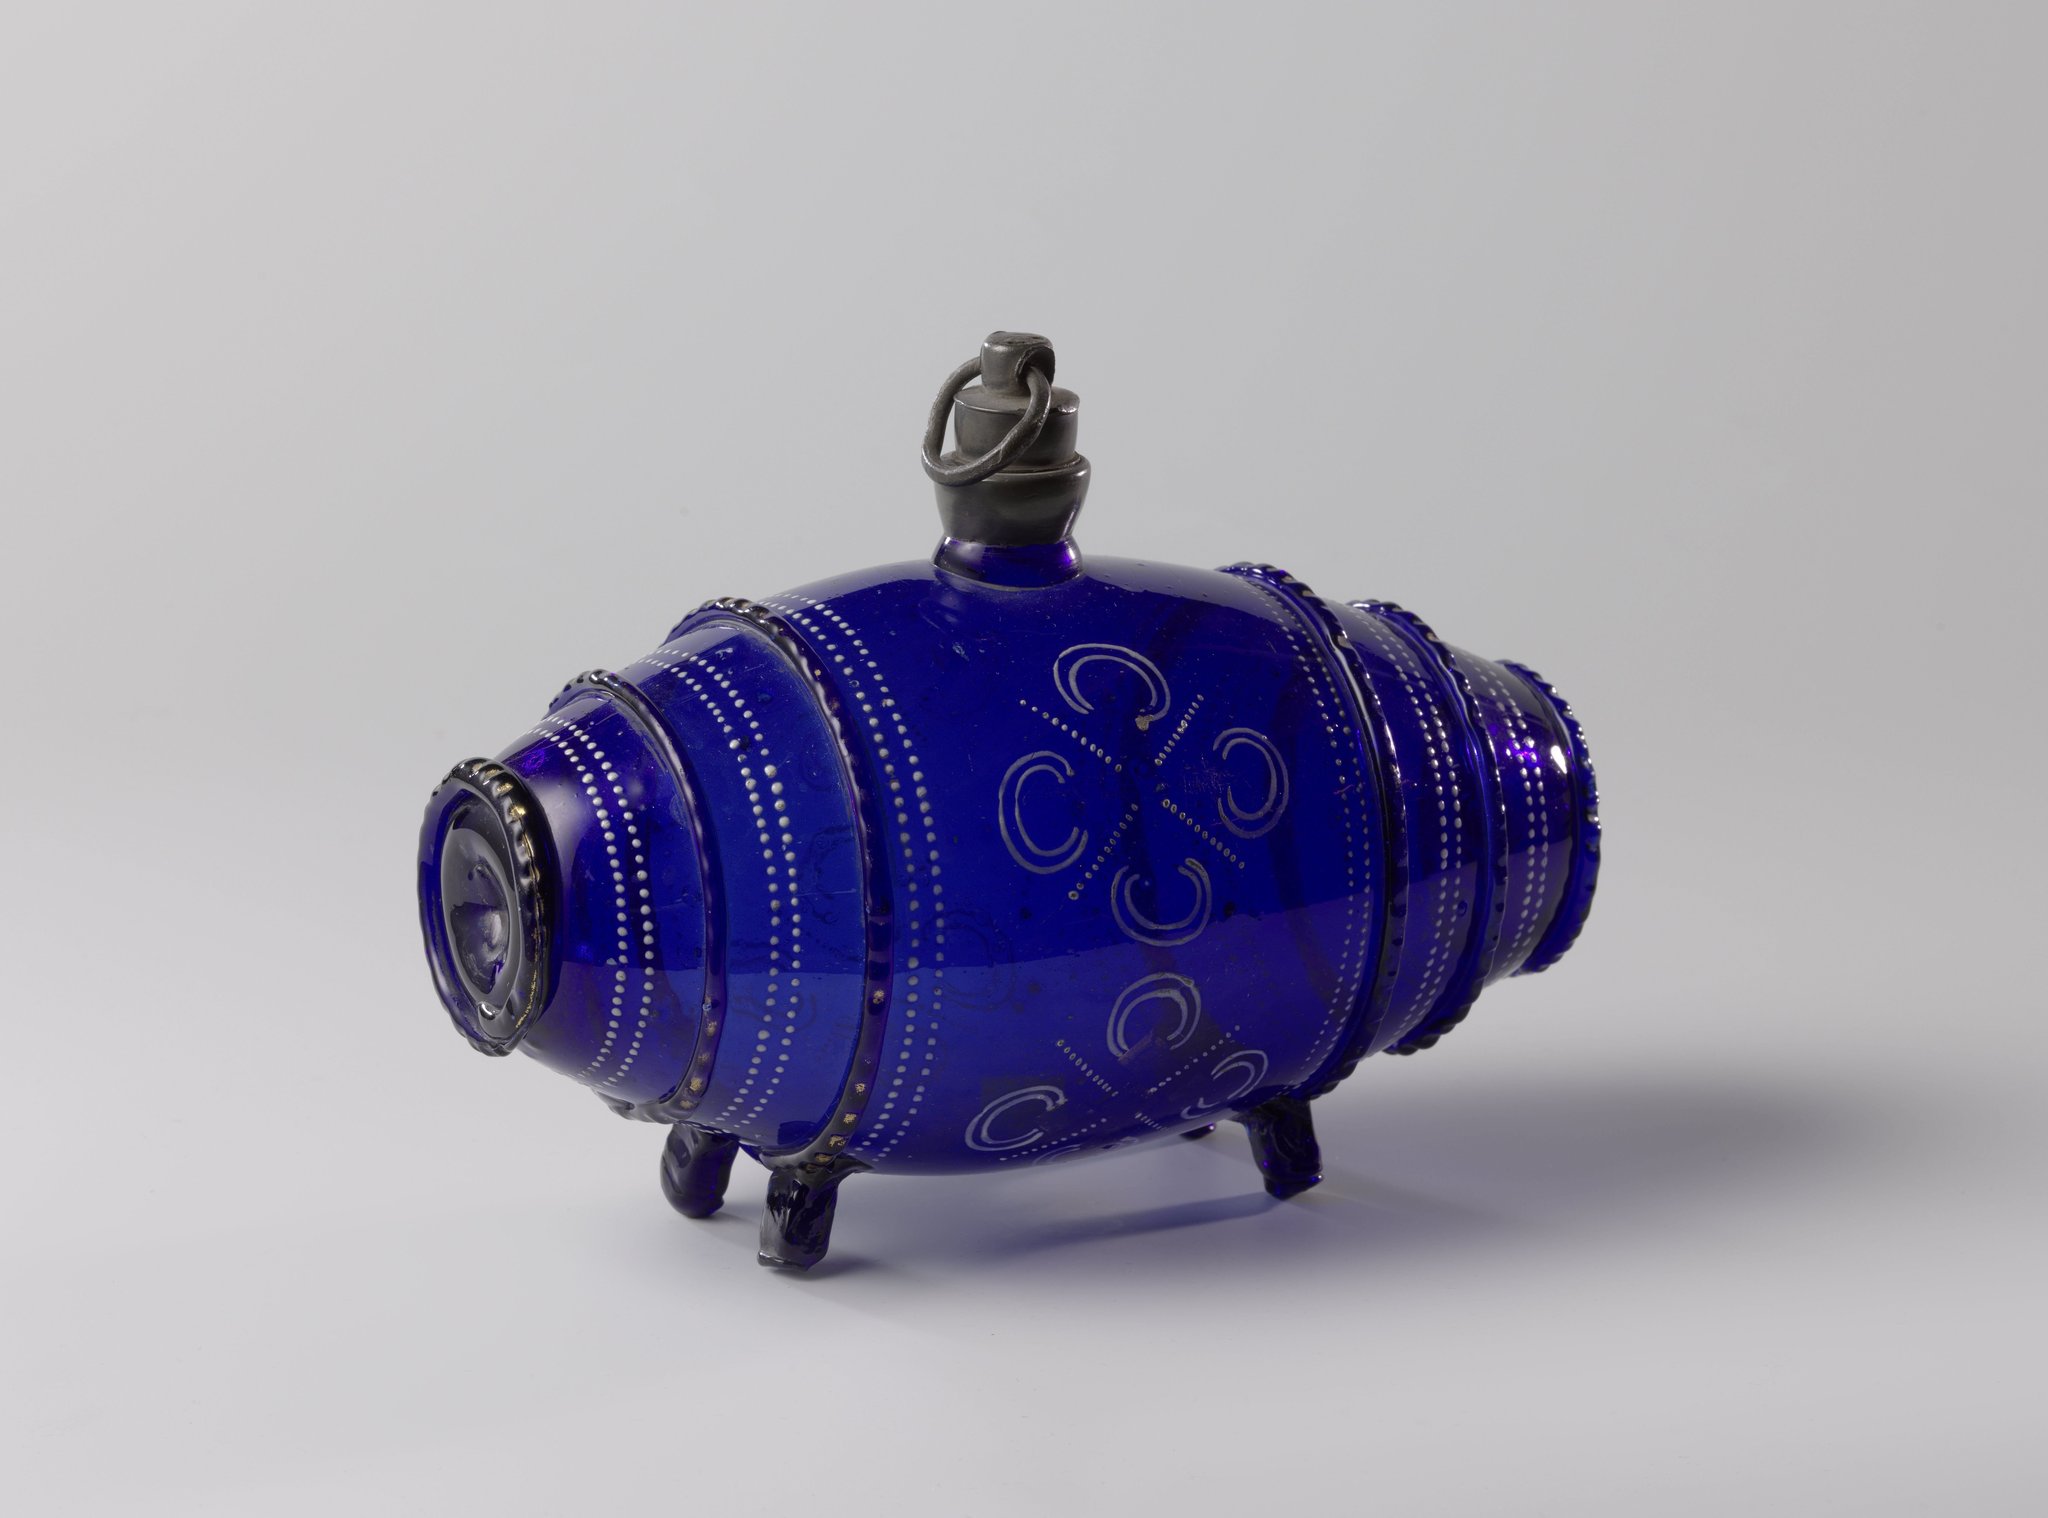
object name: trick glass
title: Fles in de vorm van een ton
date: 1700-1800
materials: glass, tin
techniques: gilding, glassblowing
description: Vier rechthoekige pootjes, tonvormig lichaam waaromheen als hoepels twee maal drie geribde draden. Op het breedste punt een korte hals, gevat in een tinnen montuur met schroefdraad. Tinnen schroefdop met ring. Op de middenbaan vier witte siermotieven, aan weerszijden en tussen de hoepels dubbele gestipte witte biezen. Op de hoepels resten van verguldsel.